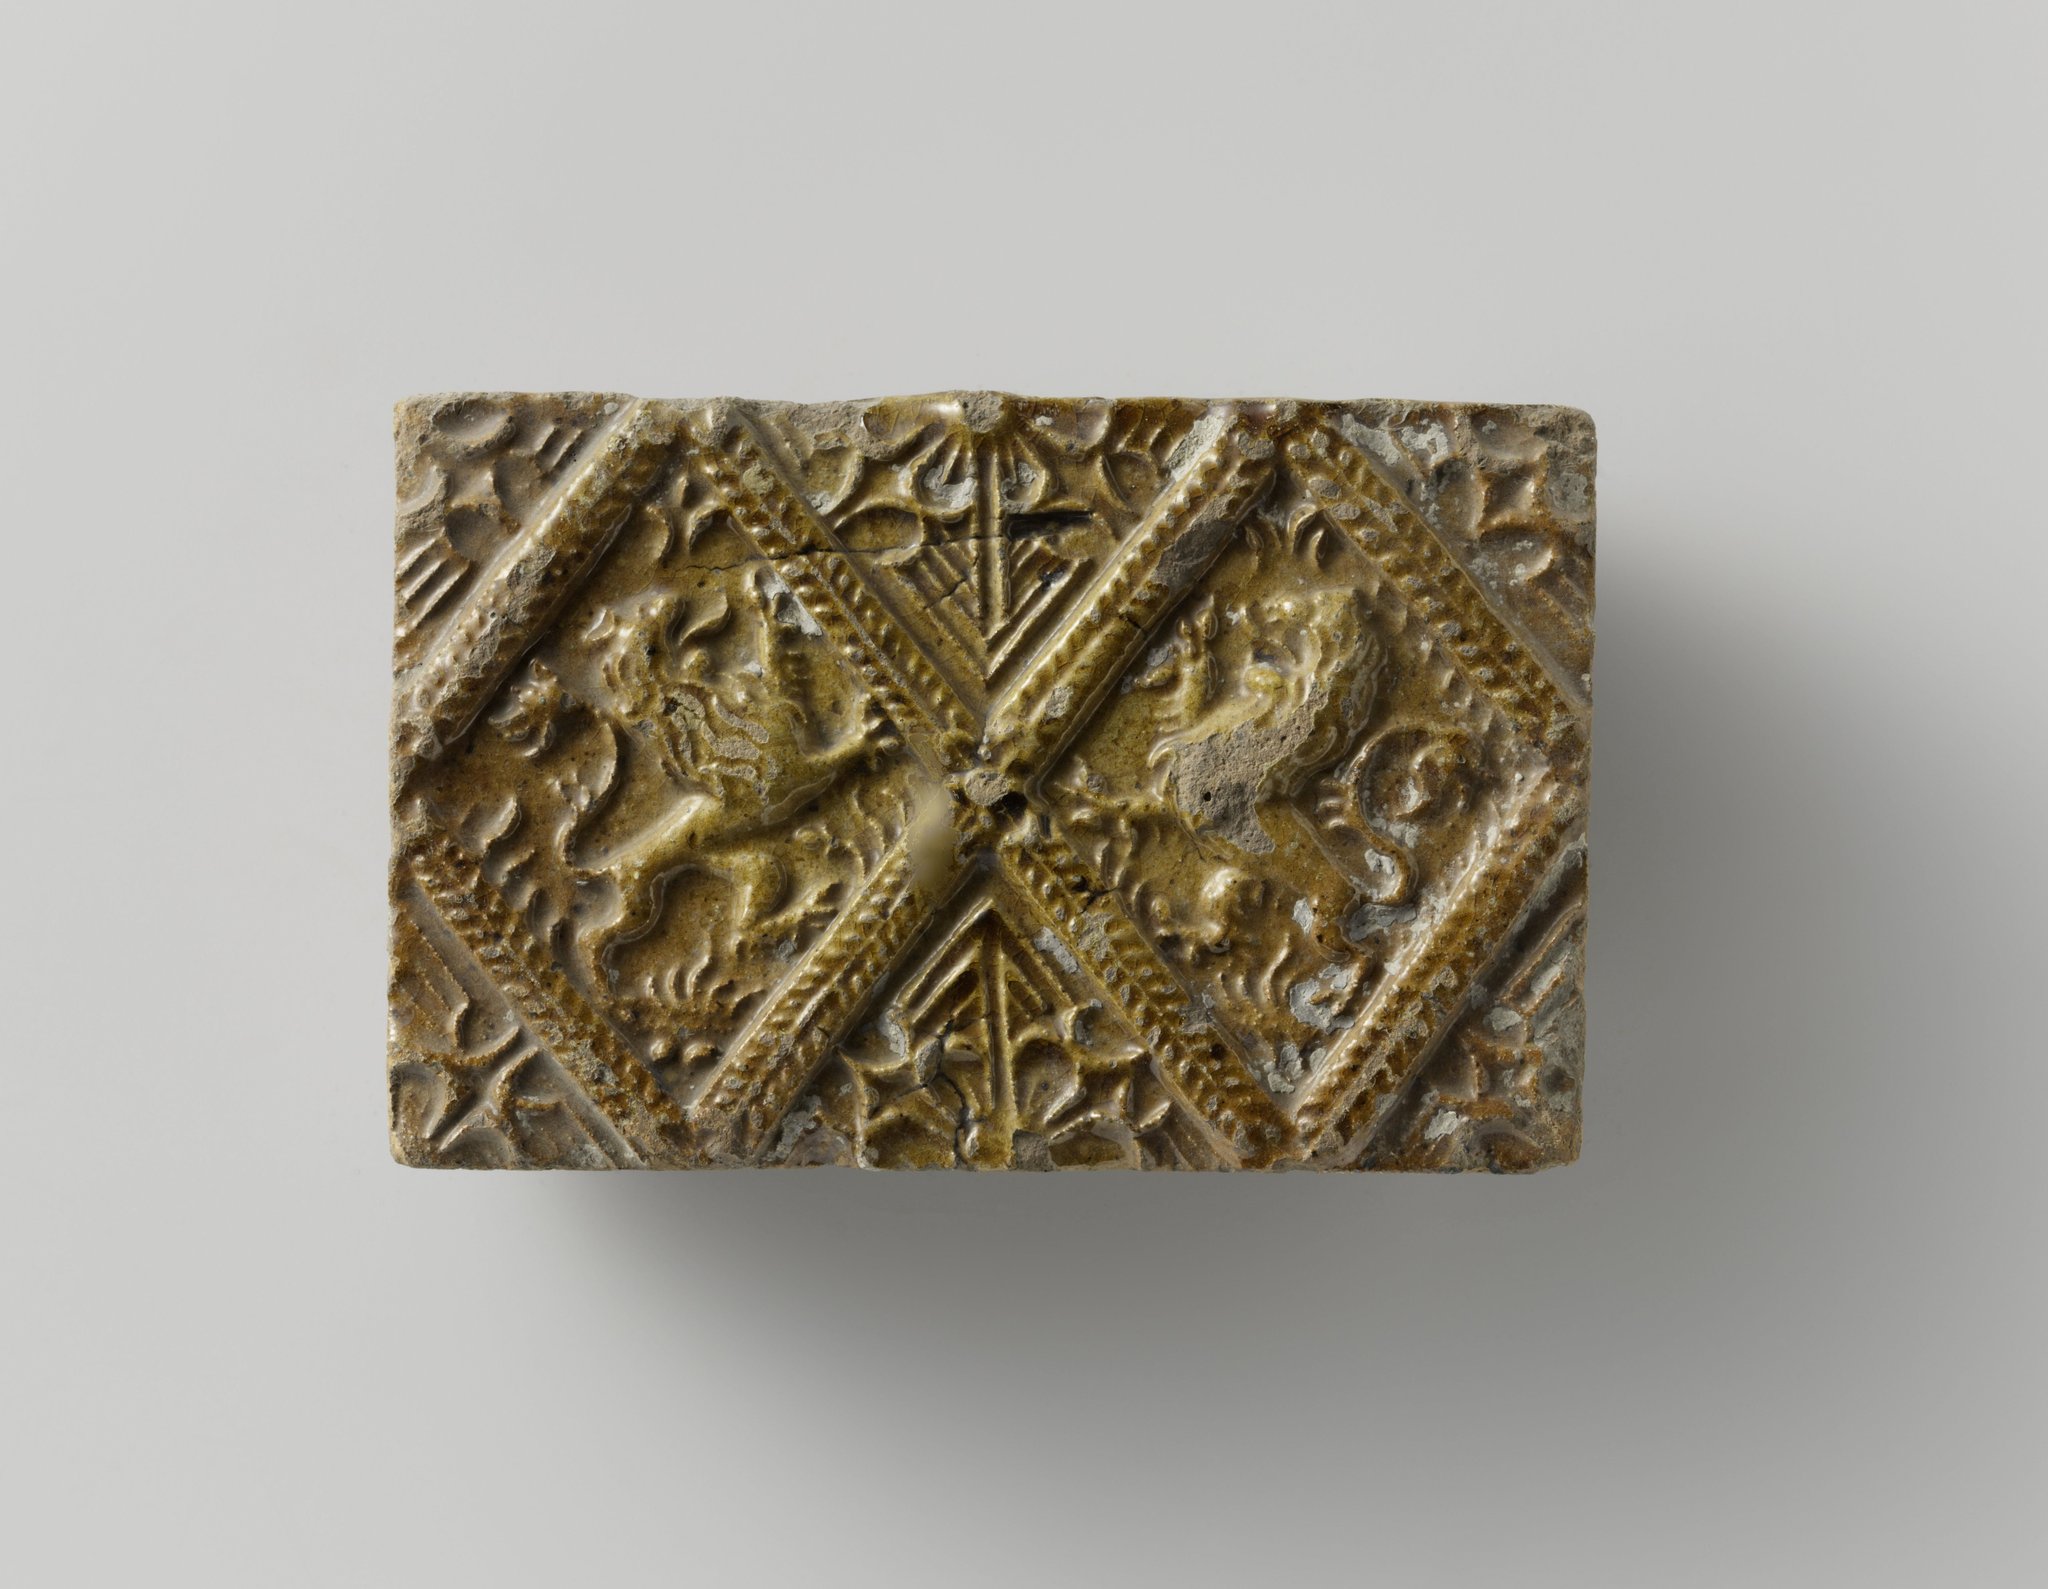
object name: hearthstone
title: haardsteen met twee klimmende leeuwen in ruiten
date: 1575-1625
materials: earthenware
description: geglazuurde haardsteen met twee klimmende leeuwen, geplaatst in twee ruiten met laurierbladmotief. De halve en kwart ruiten aan de boven- en onderkant zijn opgevuld met een bloemmotief.